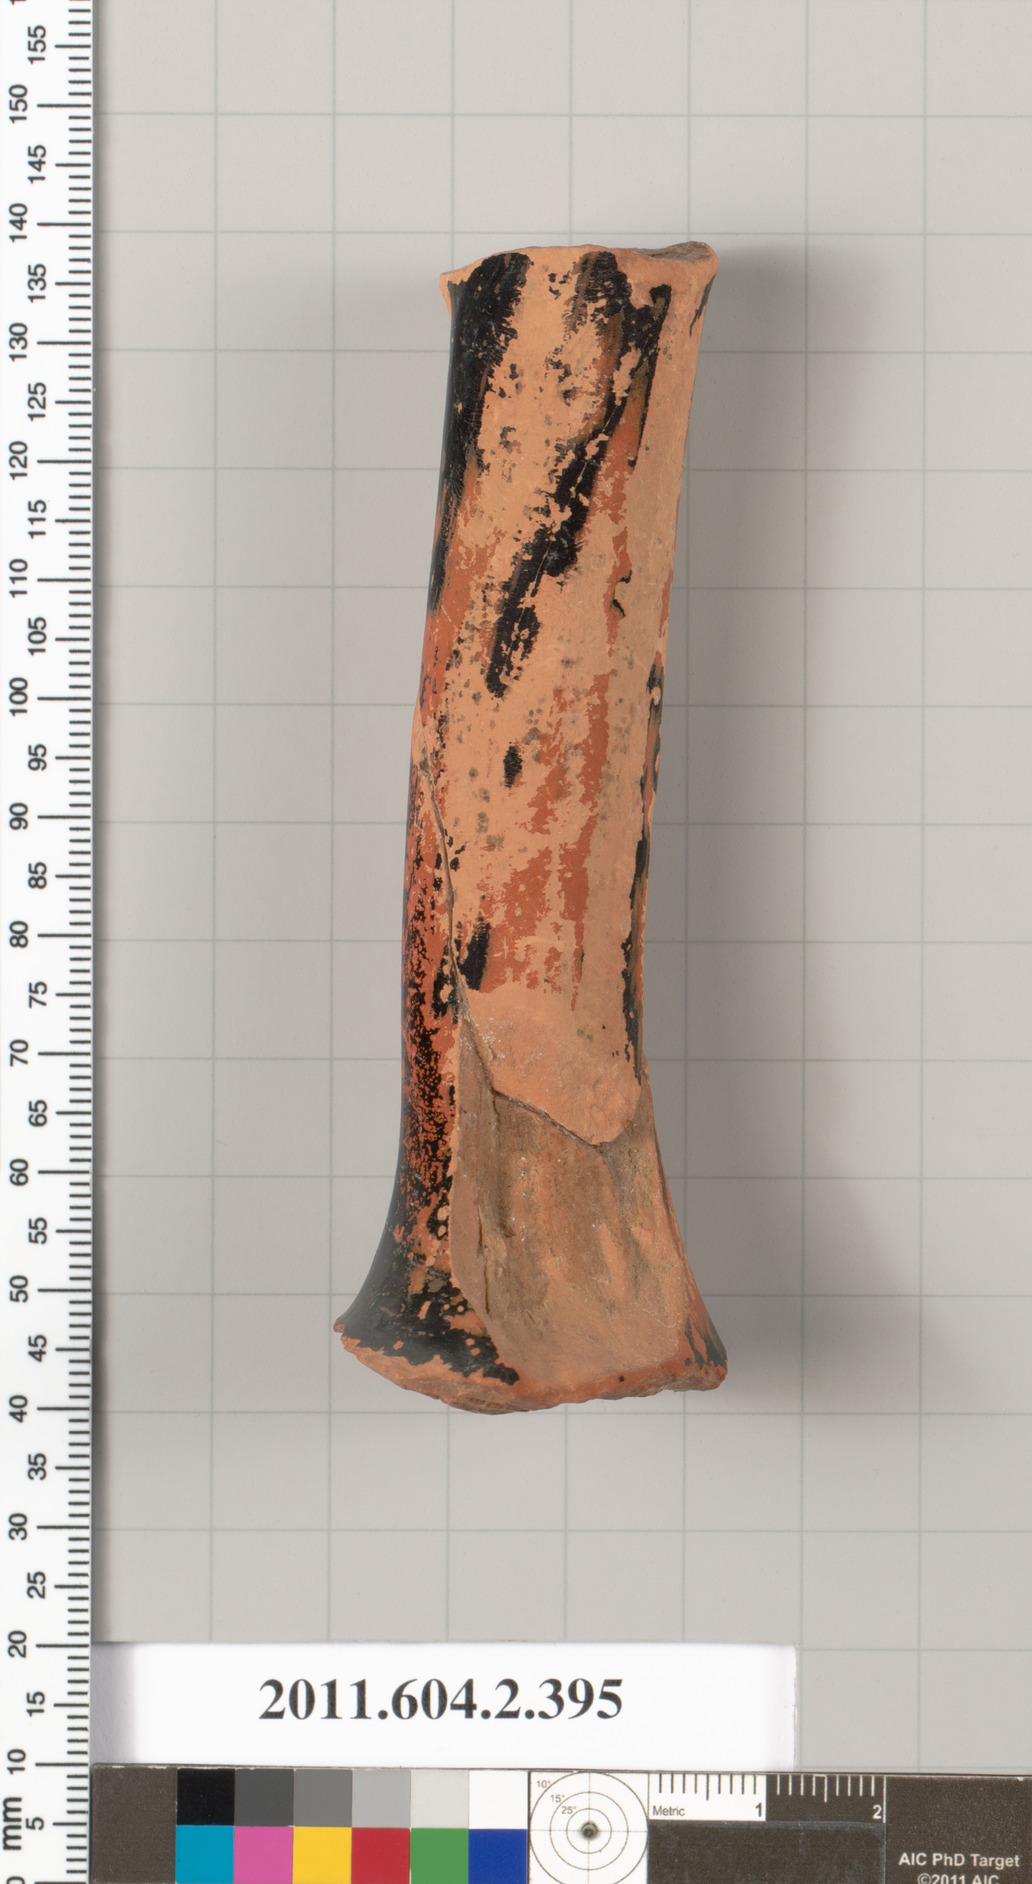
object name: column krater fragment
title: Terracotta fragment of a column-krater (bowl for mixing wine and water)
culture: greek, attic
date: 450-430 BCE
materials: terracotta